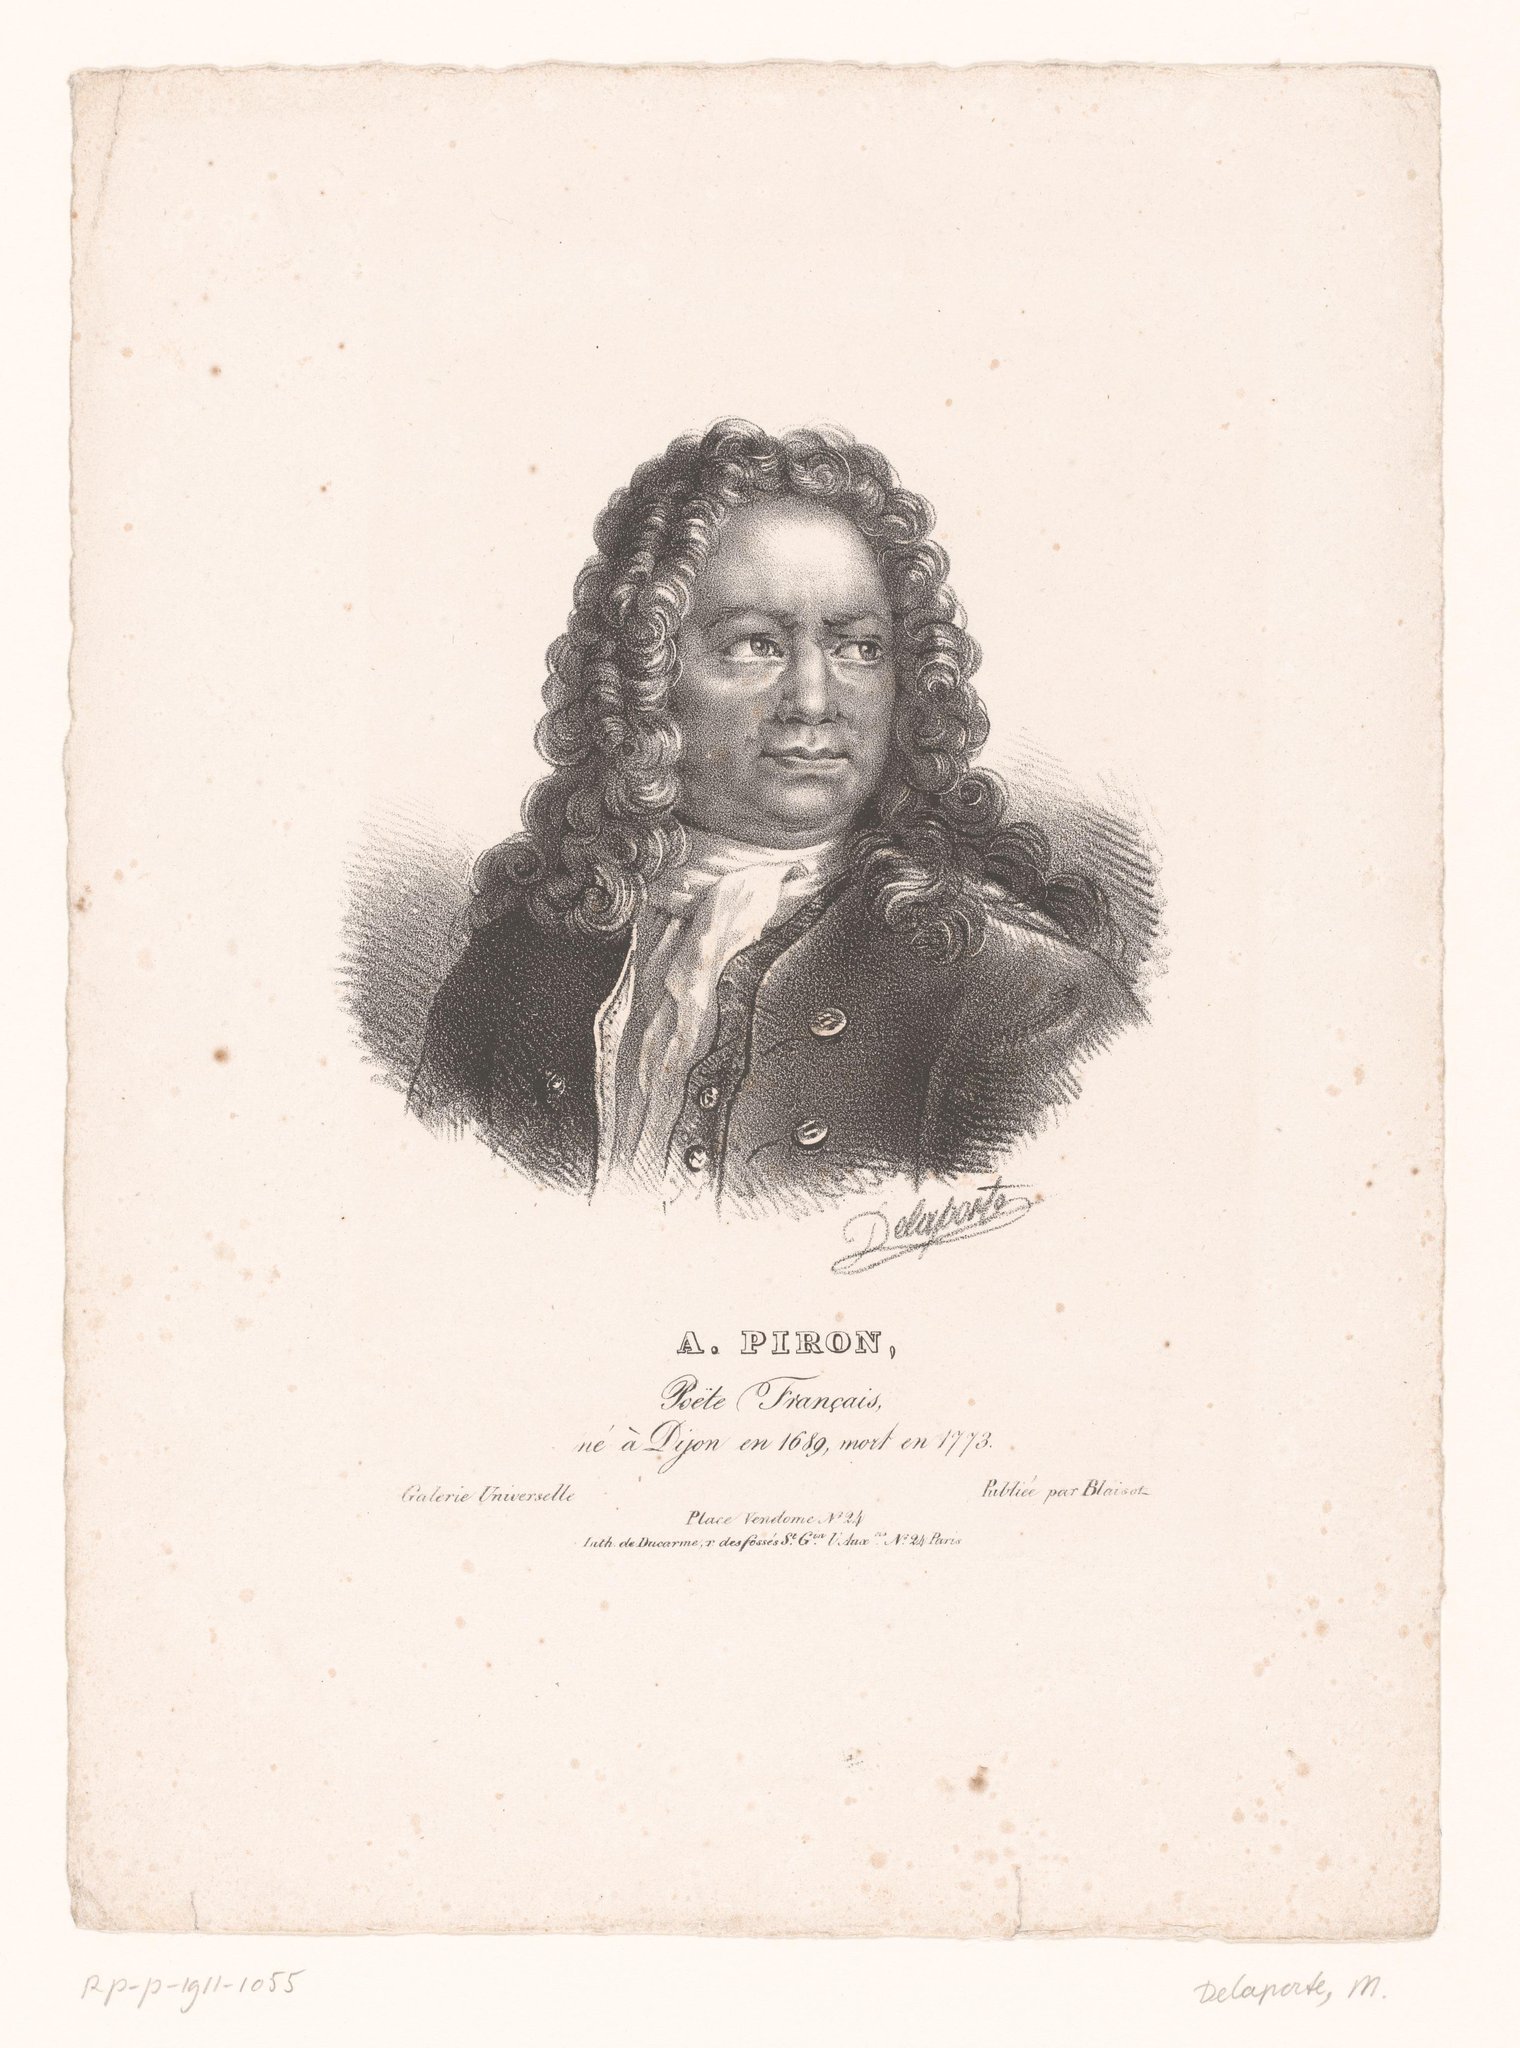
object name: print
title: A. Piron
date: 1820-1829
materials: paper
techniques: lithograph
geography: paris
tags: historical persons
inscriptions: collector's mark: Lugt 2228a